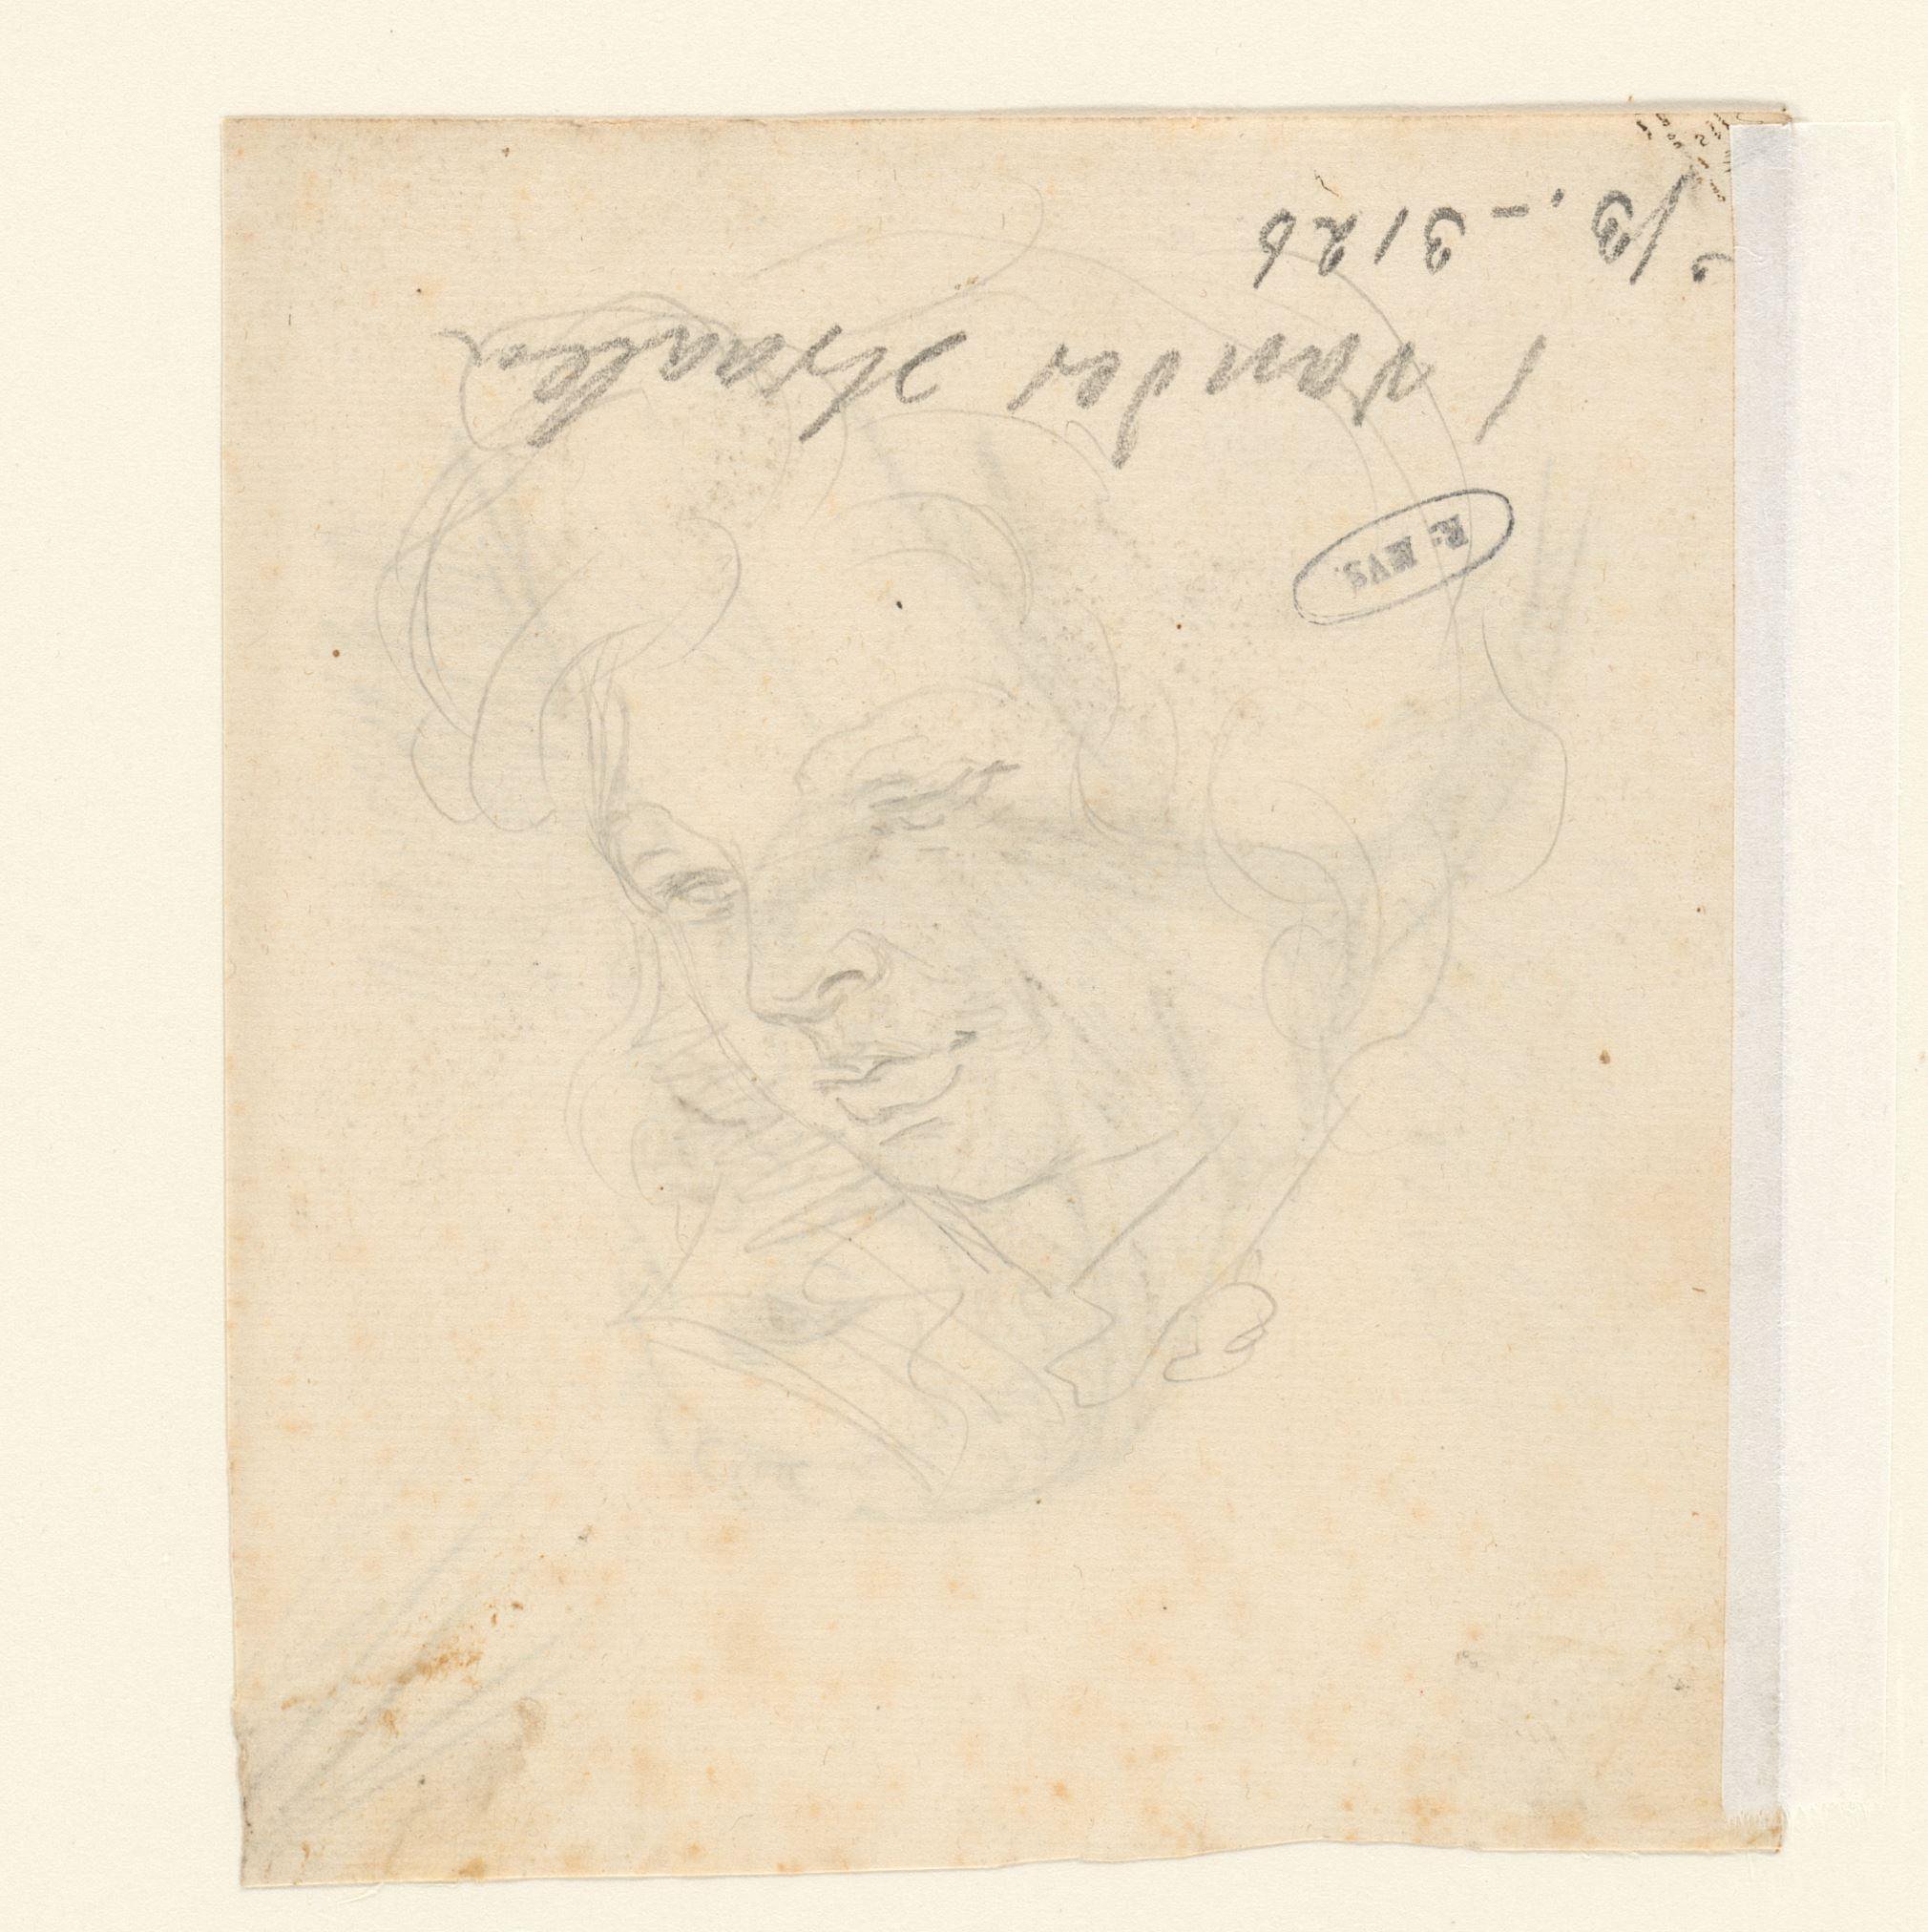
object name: drawing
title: Hoofd van een jonge vrouw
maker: van der straalen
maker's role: print maker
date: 1775-1874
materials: paper, pencil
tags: adolescent, young woman, maiden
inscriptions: collector's mark: Lugt 2228